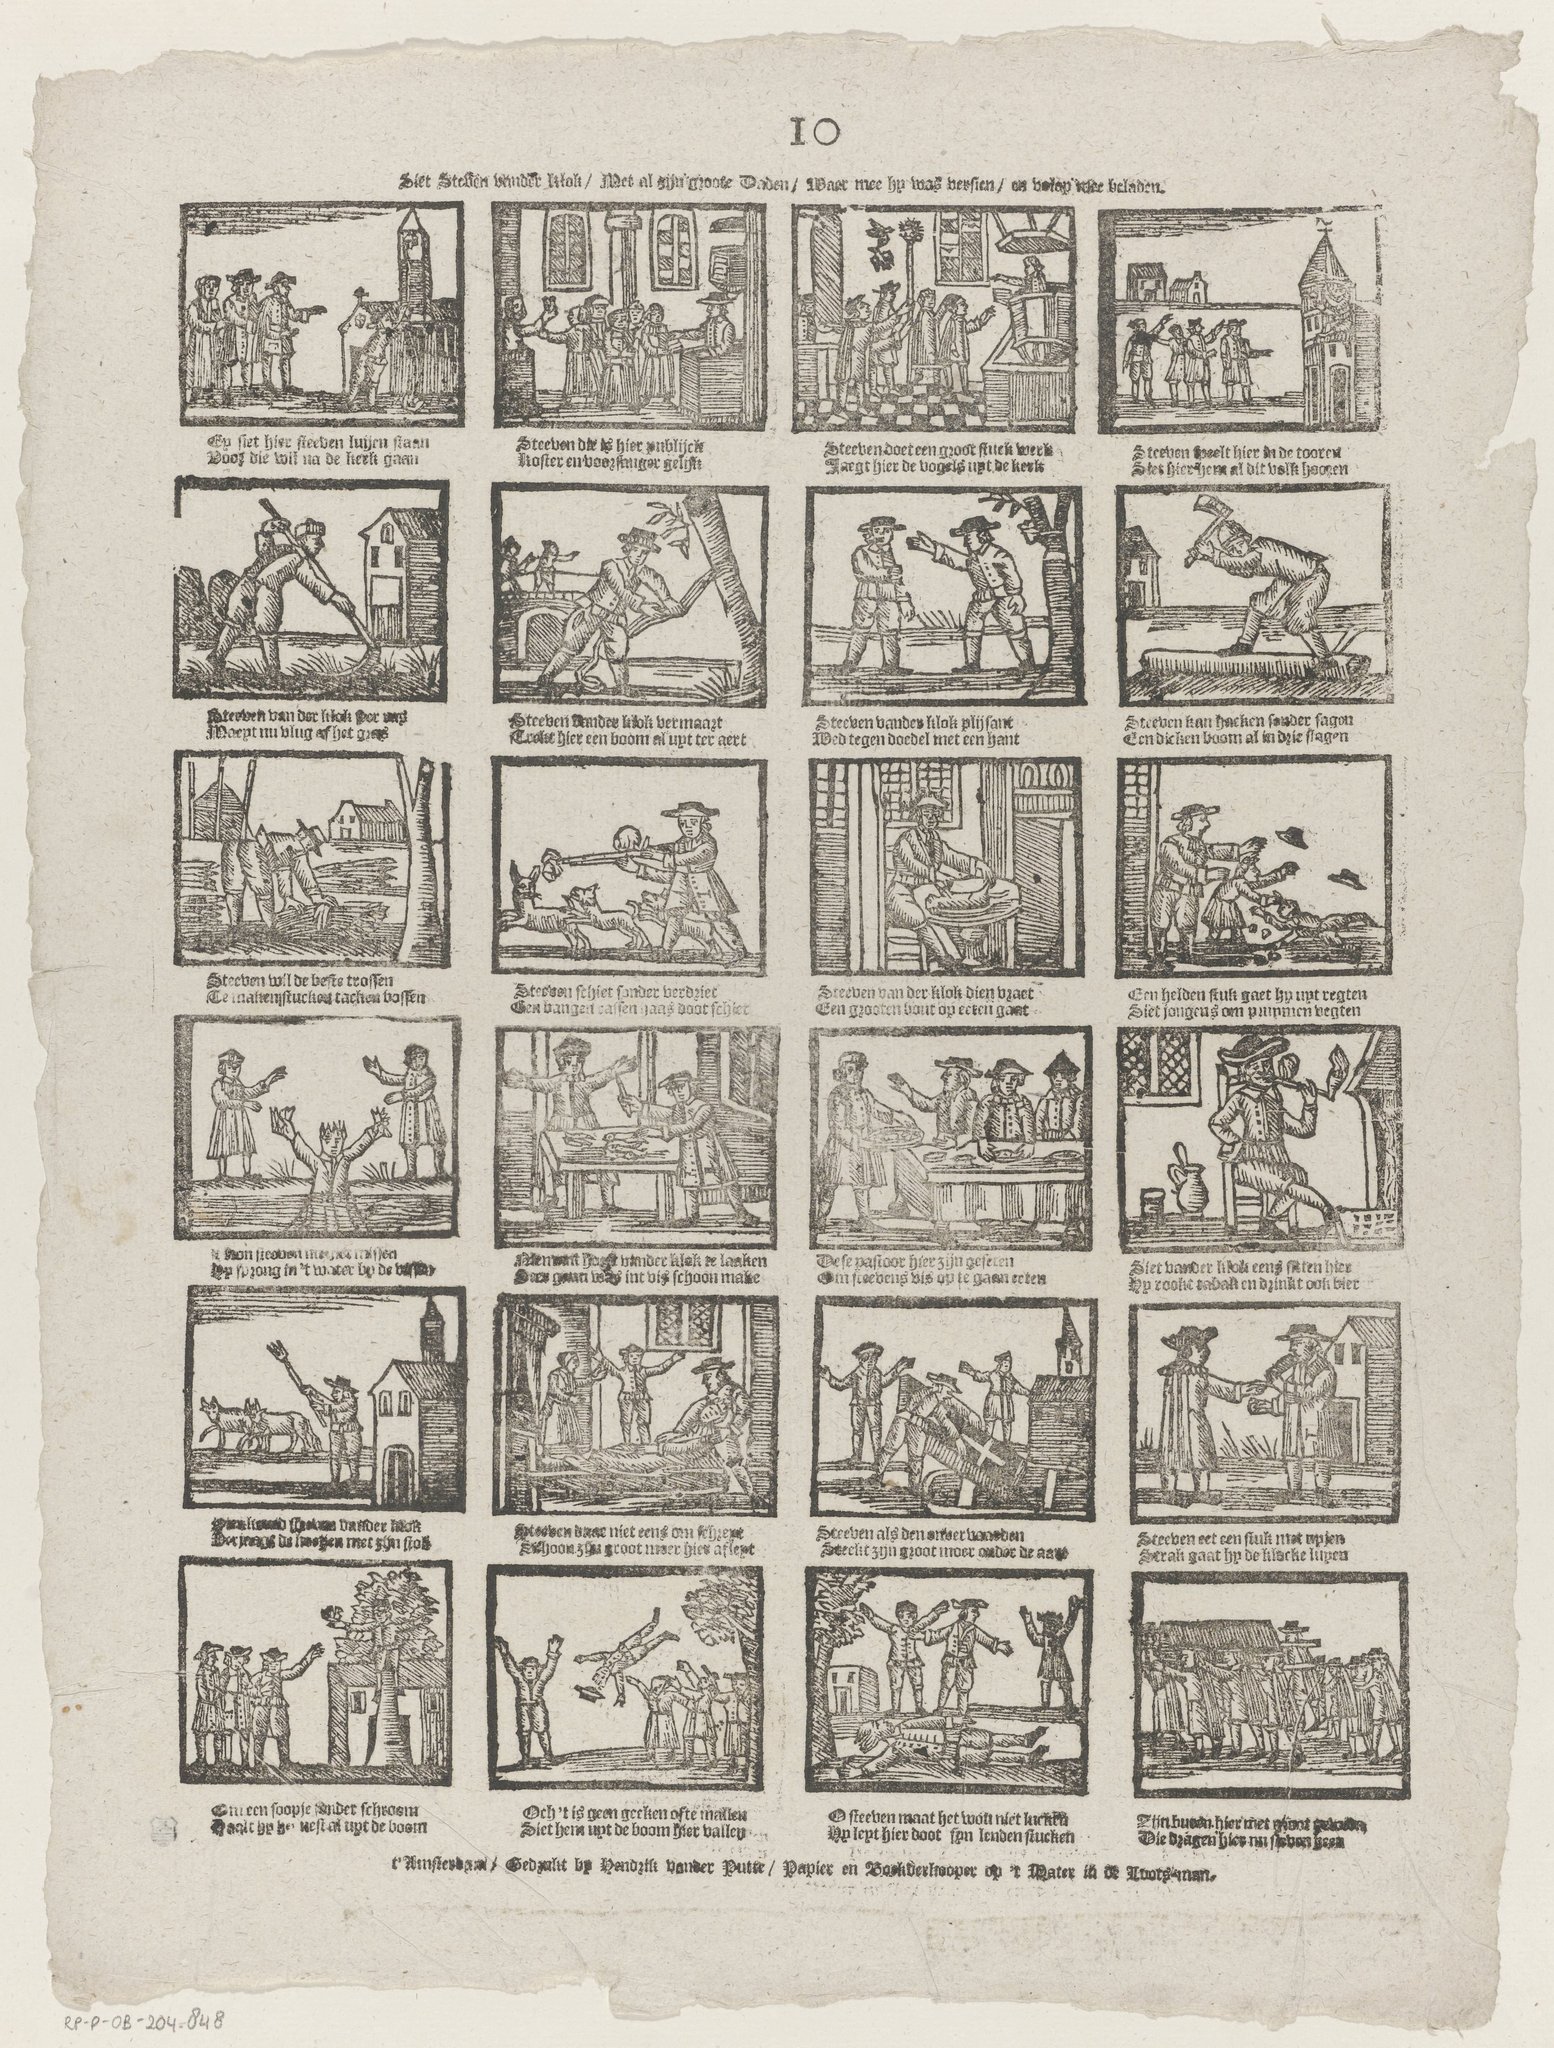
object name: print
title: Siet Steven van der Klok / Met al zijn groote sasen / Waer mee hy was versien / en volop mee beladen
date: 1761-1765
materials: paper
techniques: letterpress printing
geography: netherlands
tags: death by accident (non-violent death), funerary ceremonial, tales and fairy tales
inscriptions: collector's mark: Lugt 2760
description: Blad met 24 voorstellingen over het leven van Steven van der Klok. Onder elke afbeelding een tweeregelig vers. Genummerd midden boven: 10.